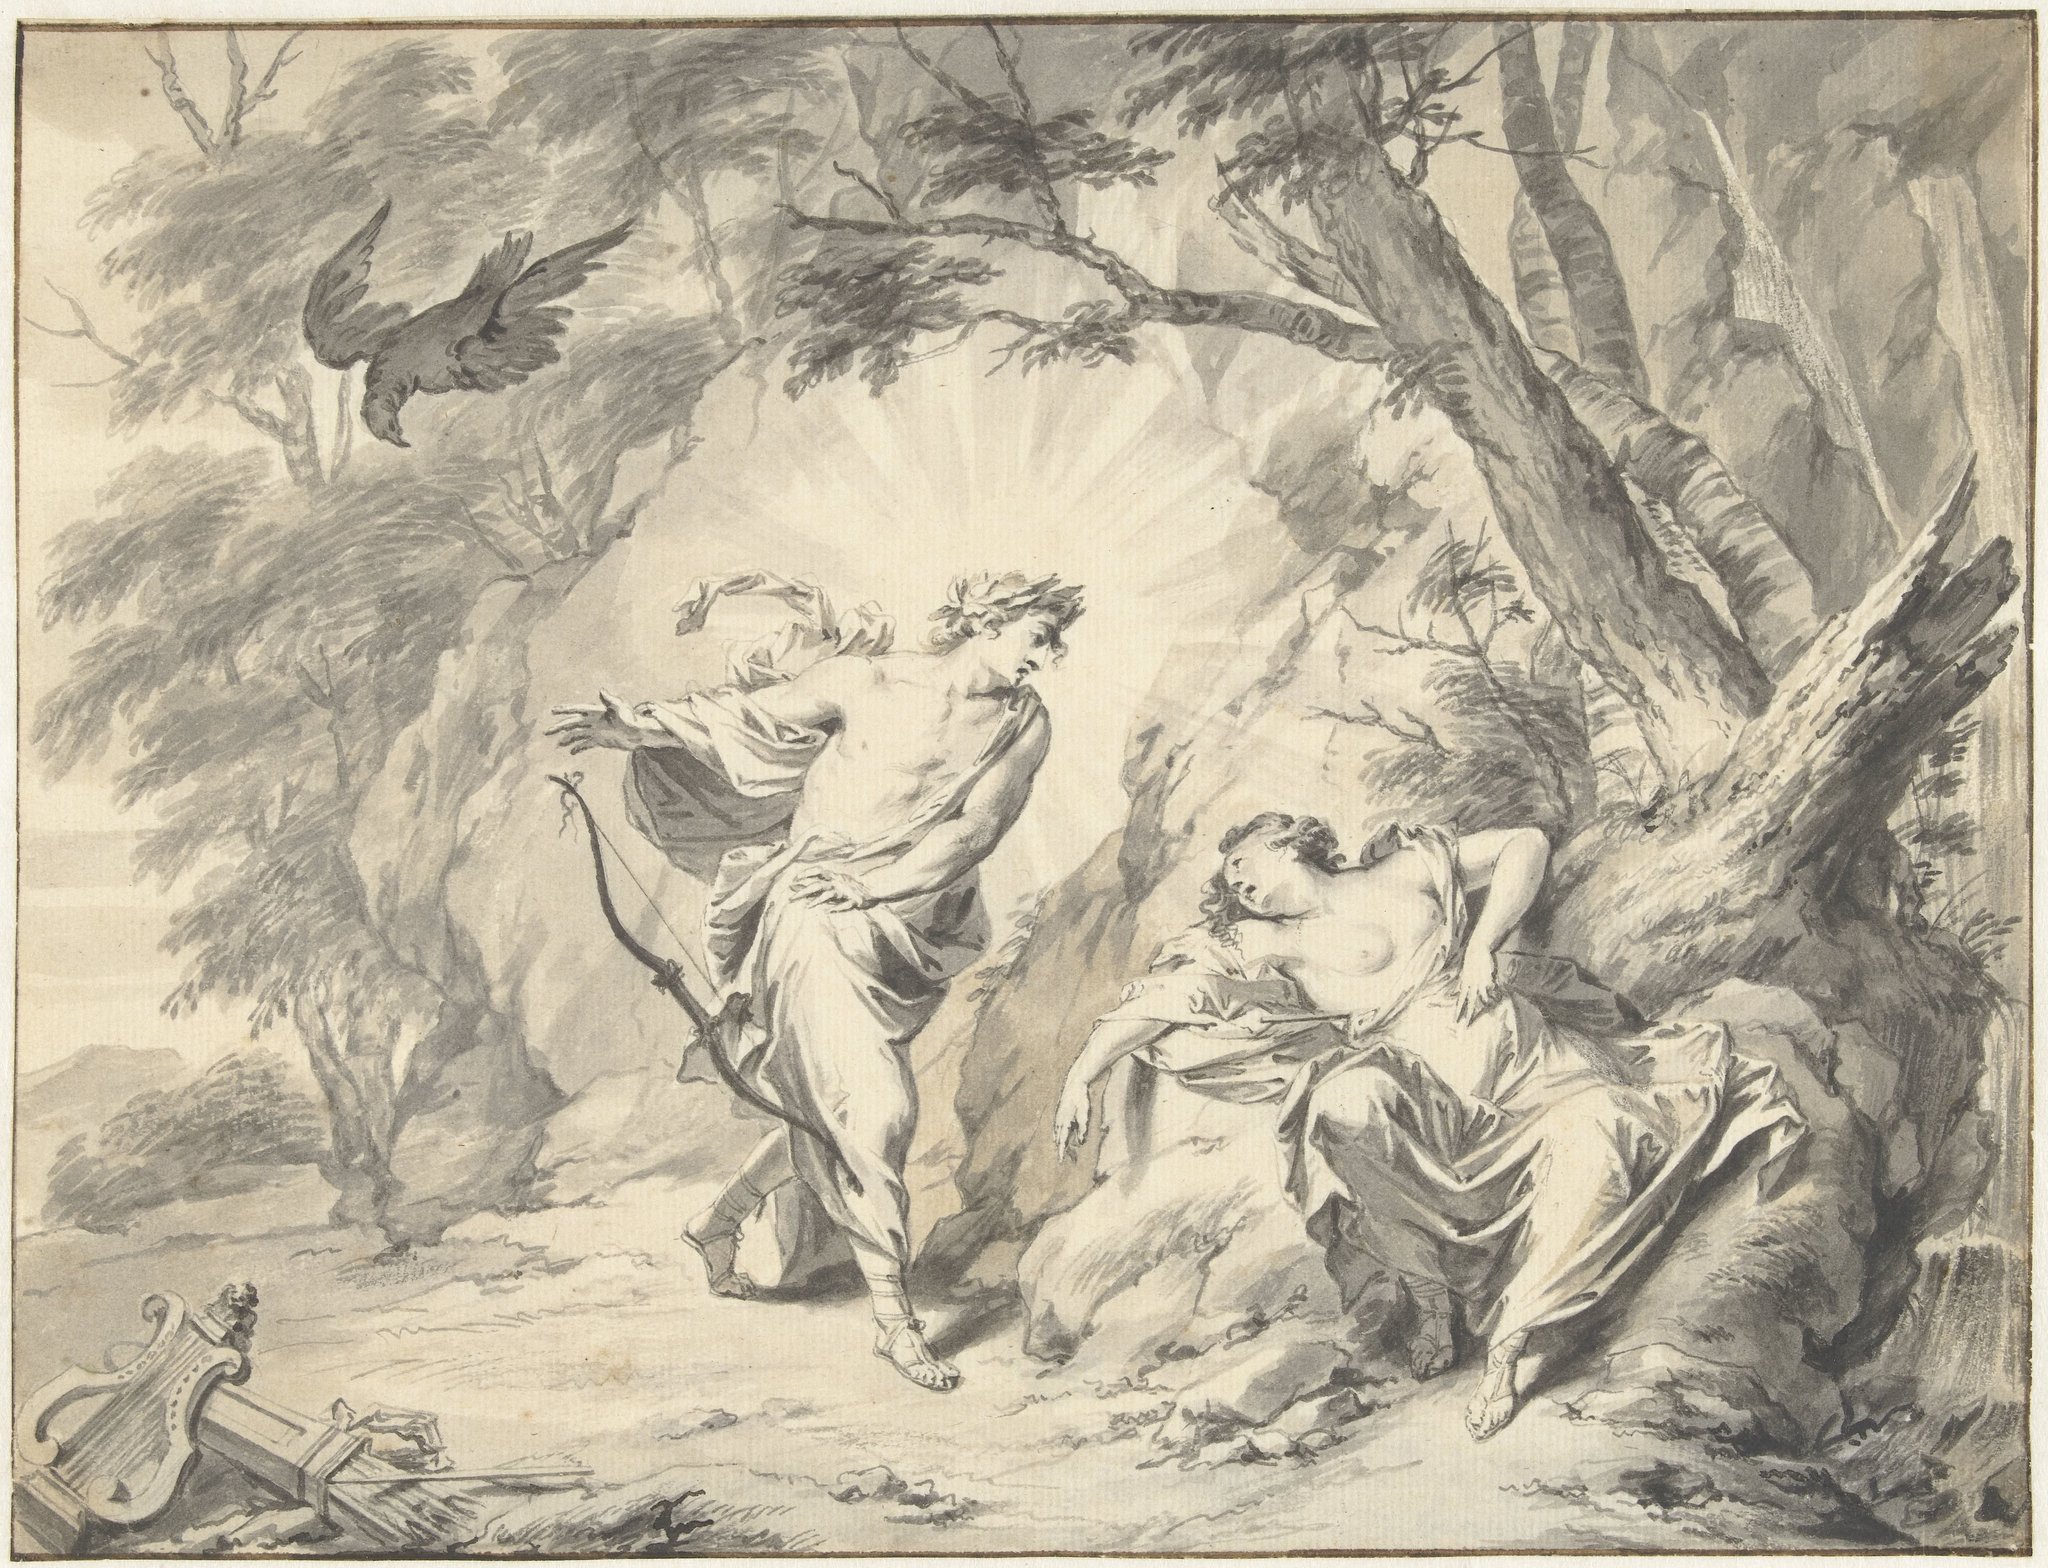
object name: design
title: Apollo doorschiet Coronis met een pijl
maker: jacob de wit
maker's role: draughtsman, painter, print maker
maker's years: 1695-1754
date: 1706-1754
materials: graphite, ink, paper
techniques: brush, pen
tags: apollo shoots coronis, but repenting his act he tries in vain to recall her to life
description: Voor prent in Isaak Verburg: De gedaantewisselingen van Ovidius.